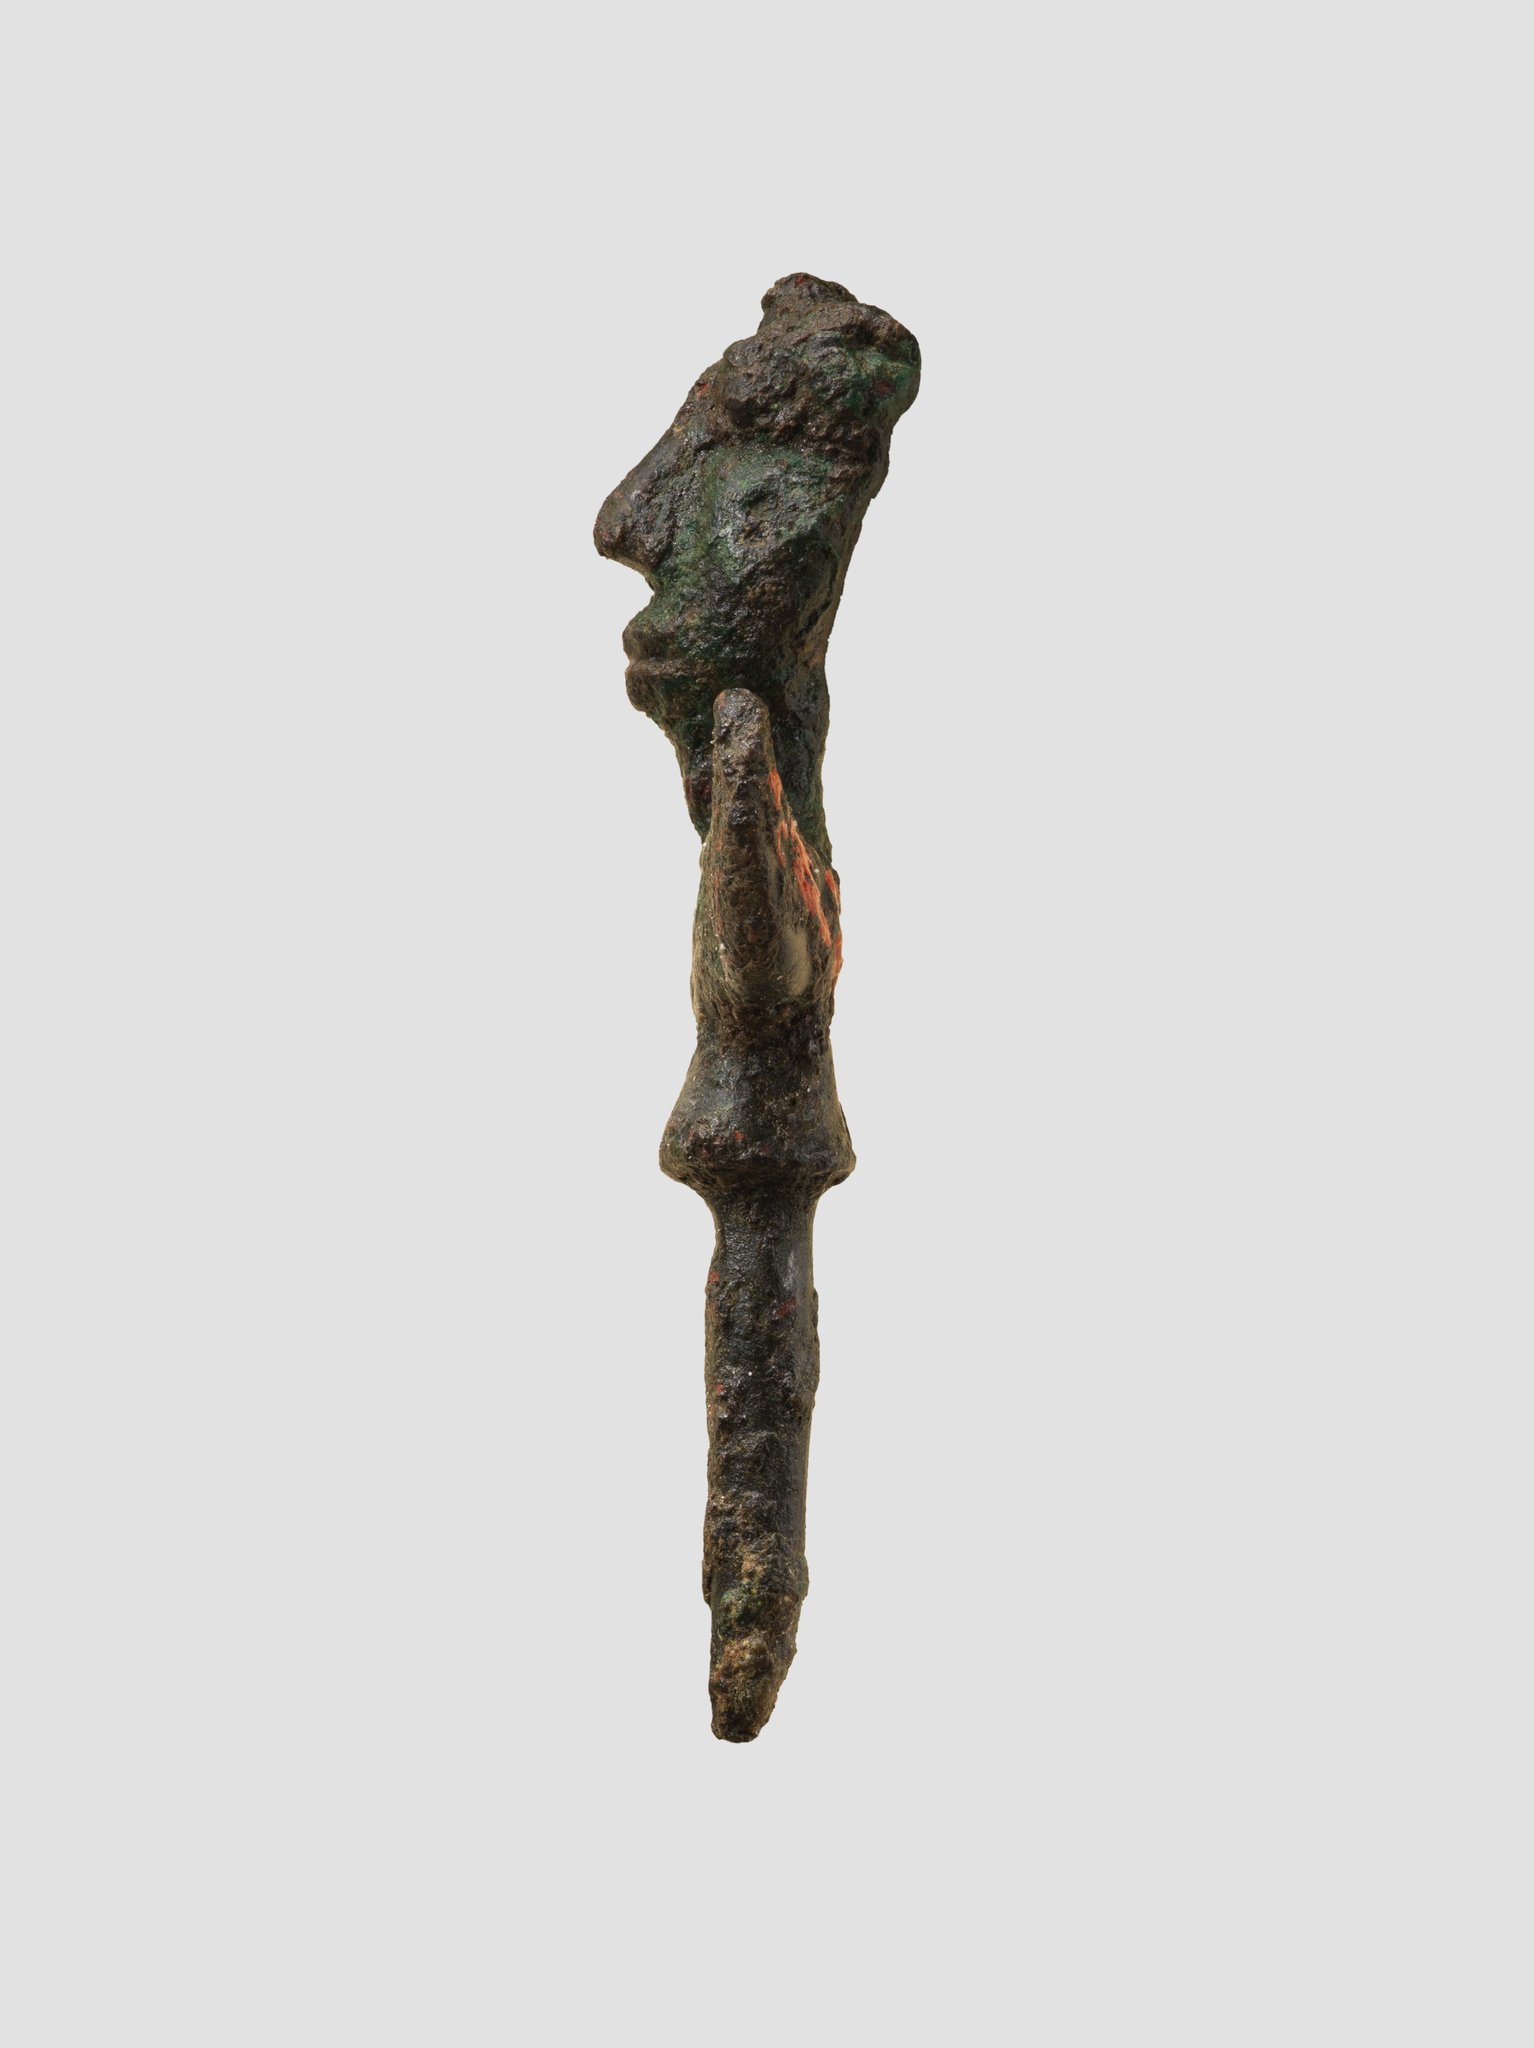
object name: pin head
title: Head of a pin: human head and wings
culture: iranian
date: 800-601 BCE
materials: bronze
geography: iran, luristan